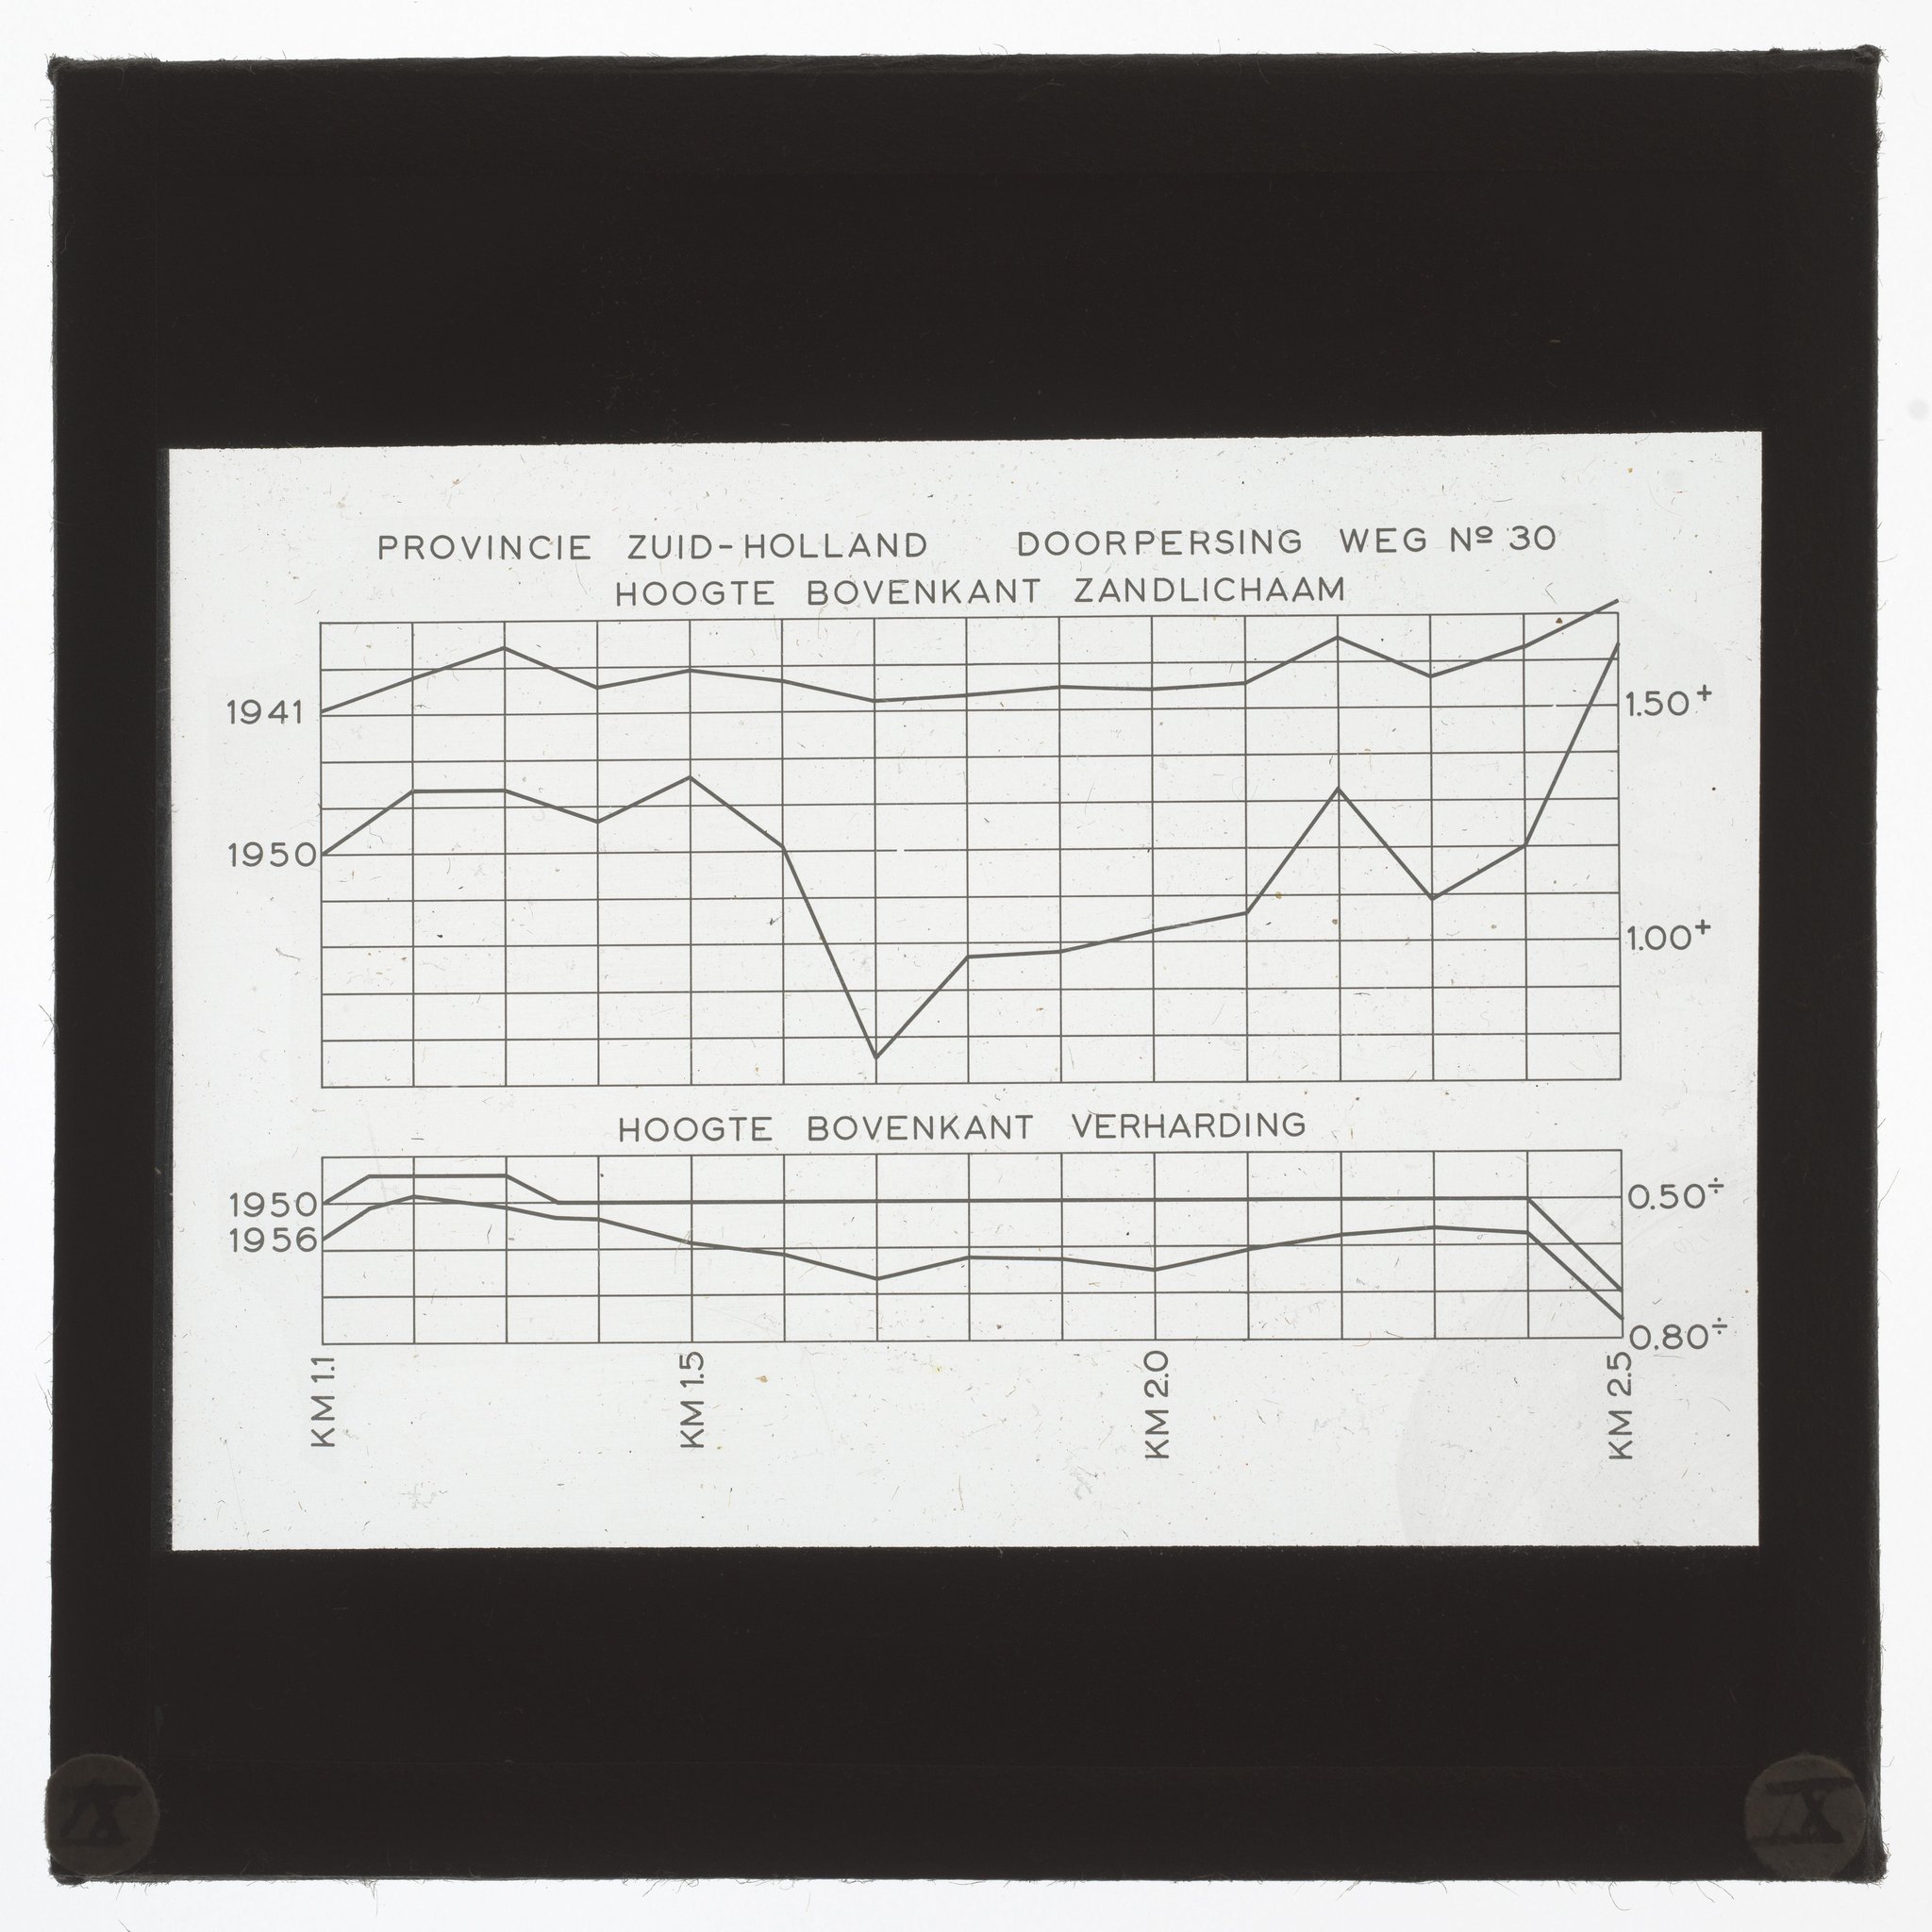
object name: photomechanical print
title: Diagram van bodemstructuren in Zuid-Holland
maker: Anonymous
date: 1956-1960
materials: glass, paper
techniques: printing block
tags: statistic diagram, graph; pictorial chart, etc., public road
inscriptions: number: ‘IX’